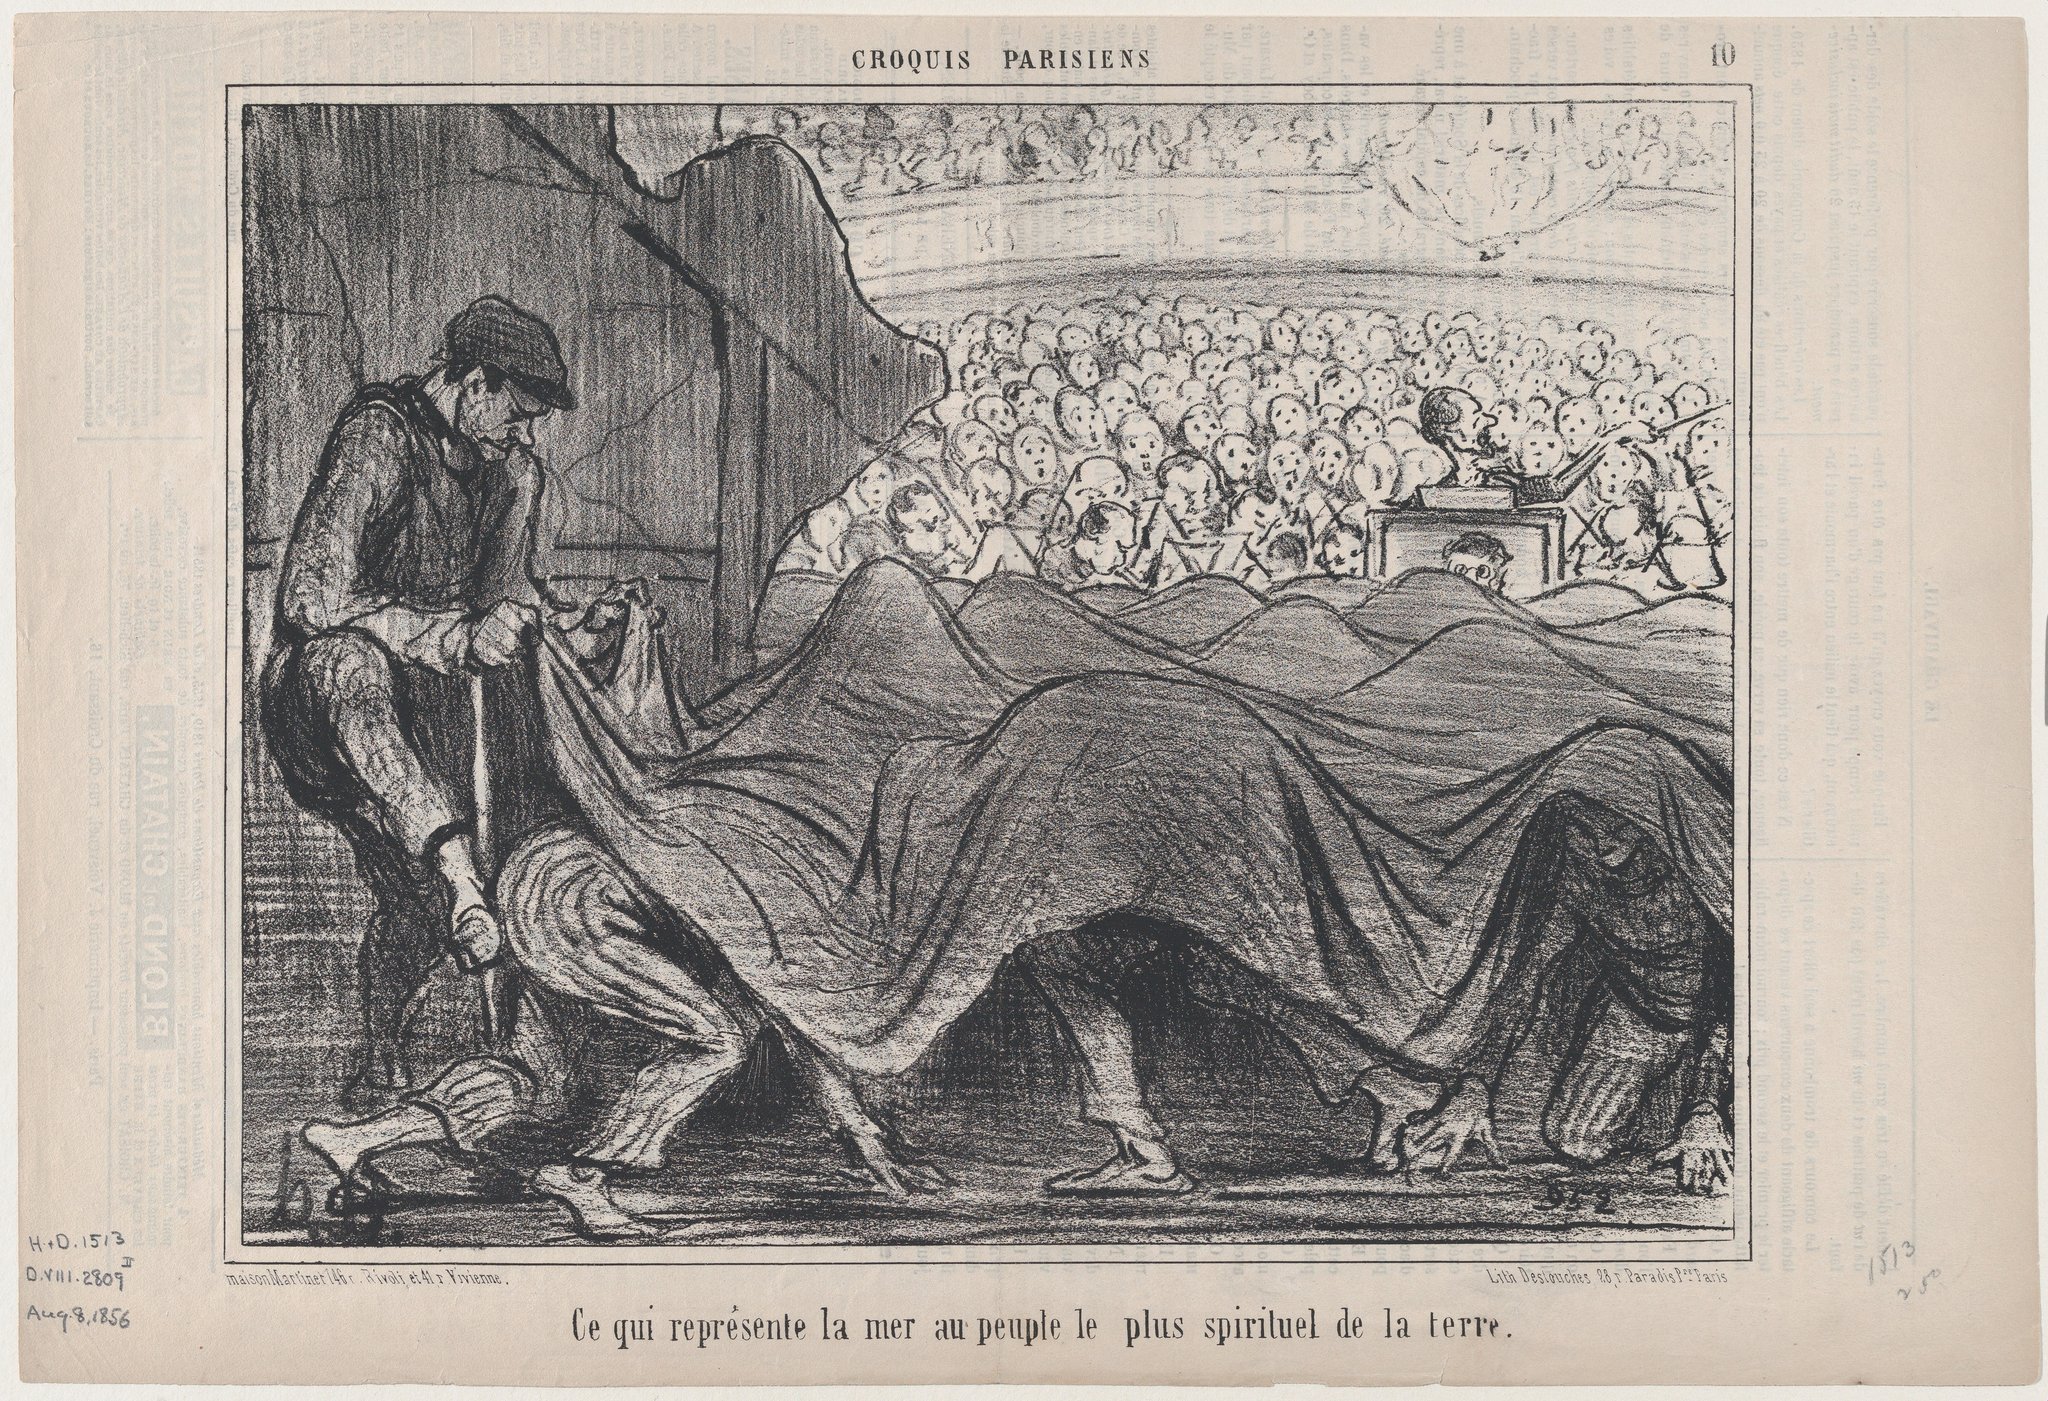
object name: print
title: Ce qui représente la mer au peuple..., from "Croquis Parisiens"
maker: honoré daumier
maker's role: artist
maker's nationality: french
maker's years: 1808-1879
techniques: lithograph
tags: crowd